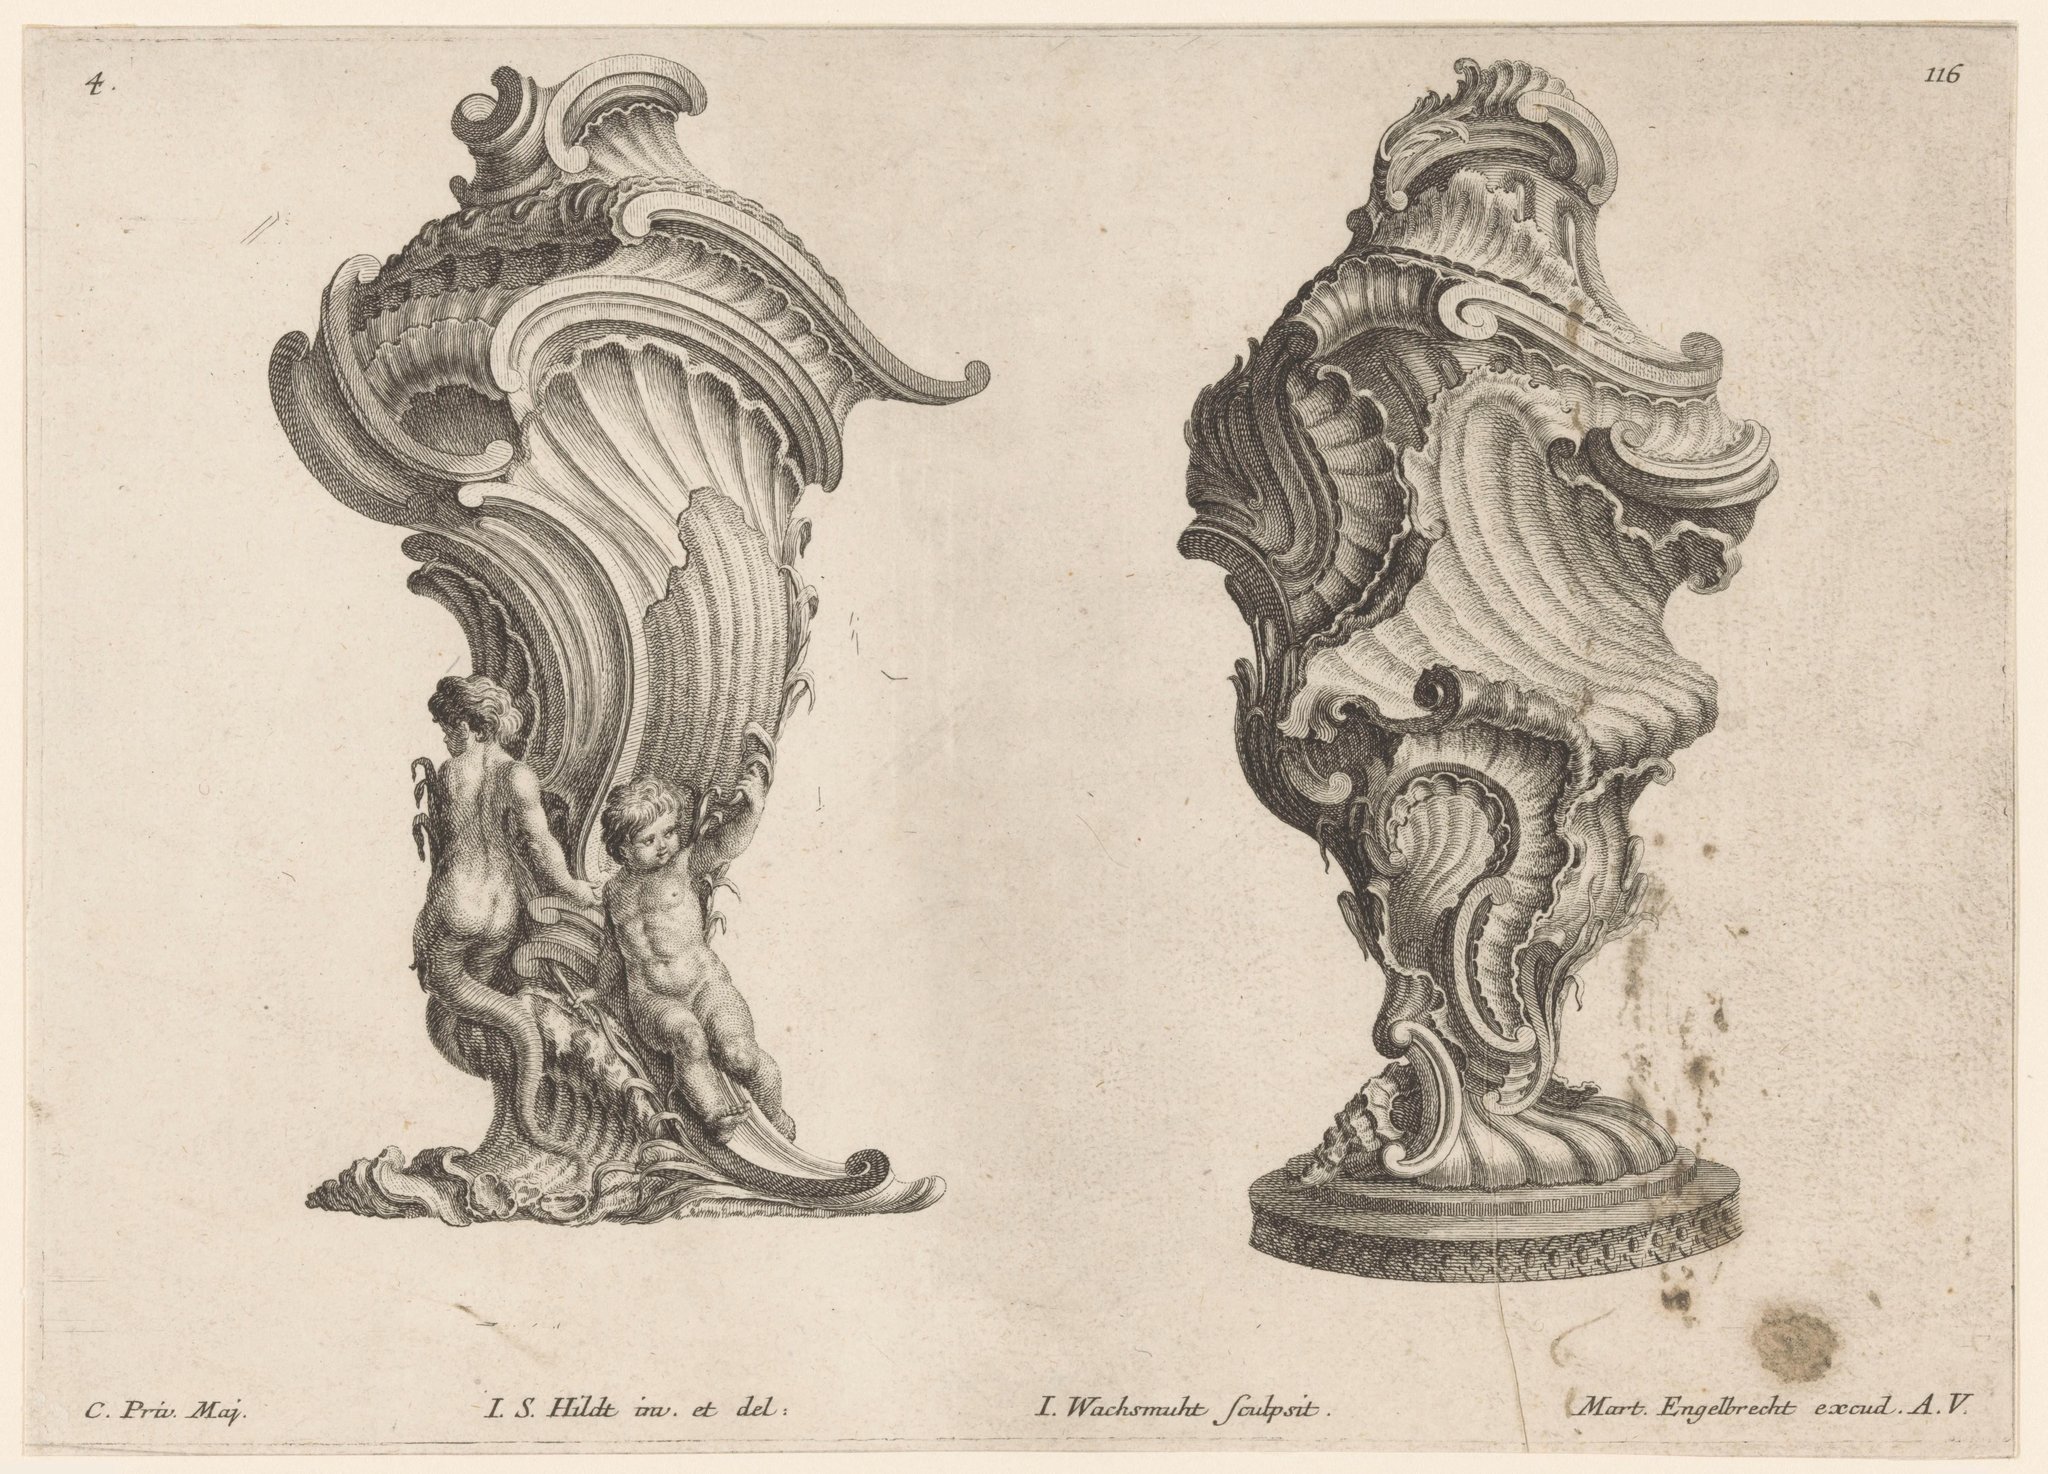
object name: print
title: Schöne und auf die neueste Facon inventierte Gefäße und Krüge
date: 1721-1756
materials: paper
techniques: etching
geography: augsburg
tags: rocaille ornament, vase ~ ornament, cupids: 'amores', 'amoretti', 'putti'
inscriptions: collector's mark: Lugt 2760, collector's mark: Lugt 2228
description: Twee rocaille siervazen. De linkervaas is met twee putti gedecoreerd. Prentnummer 116.